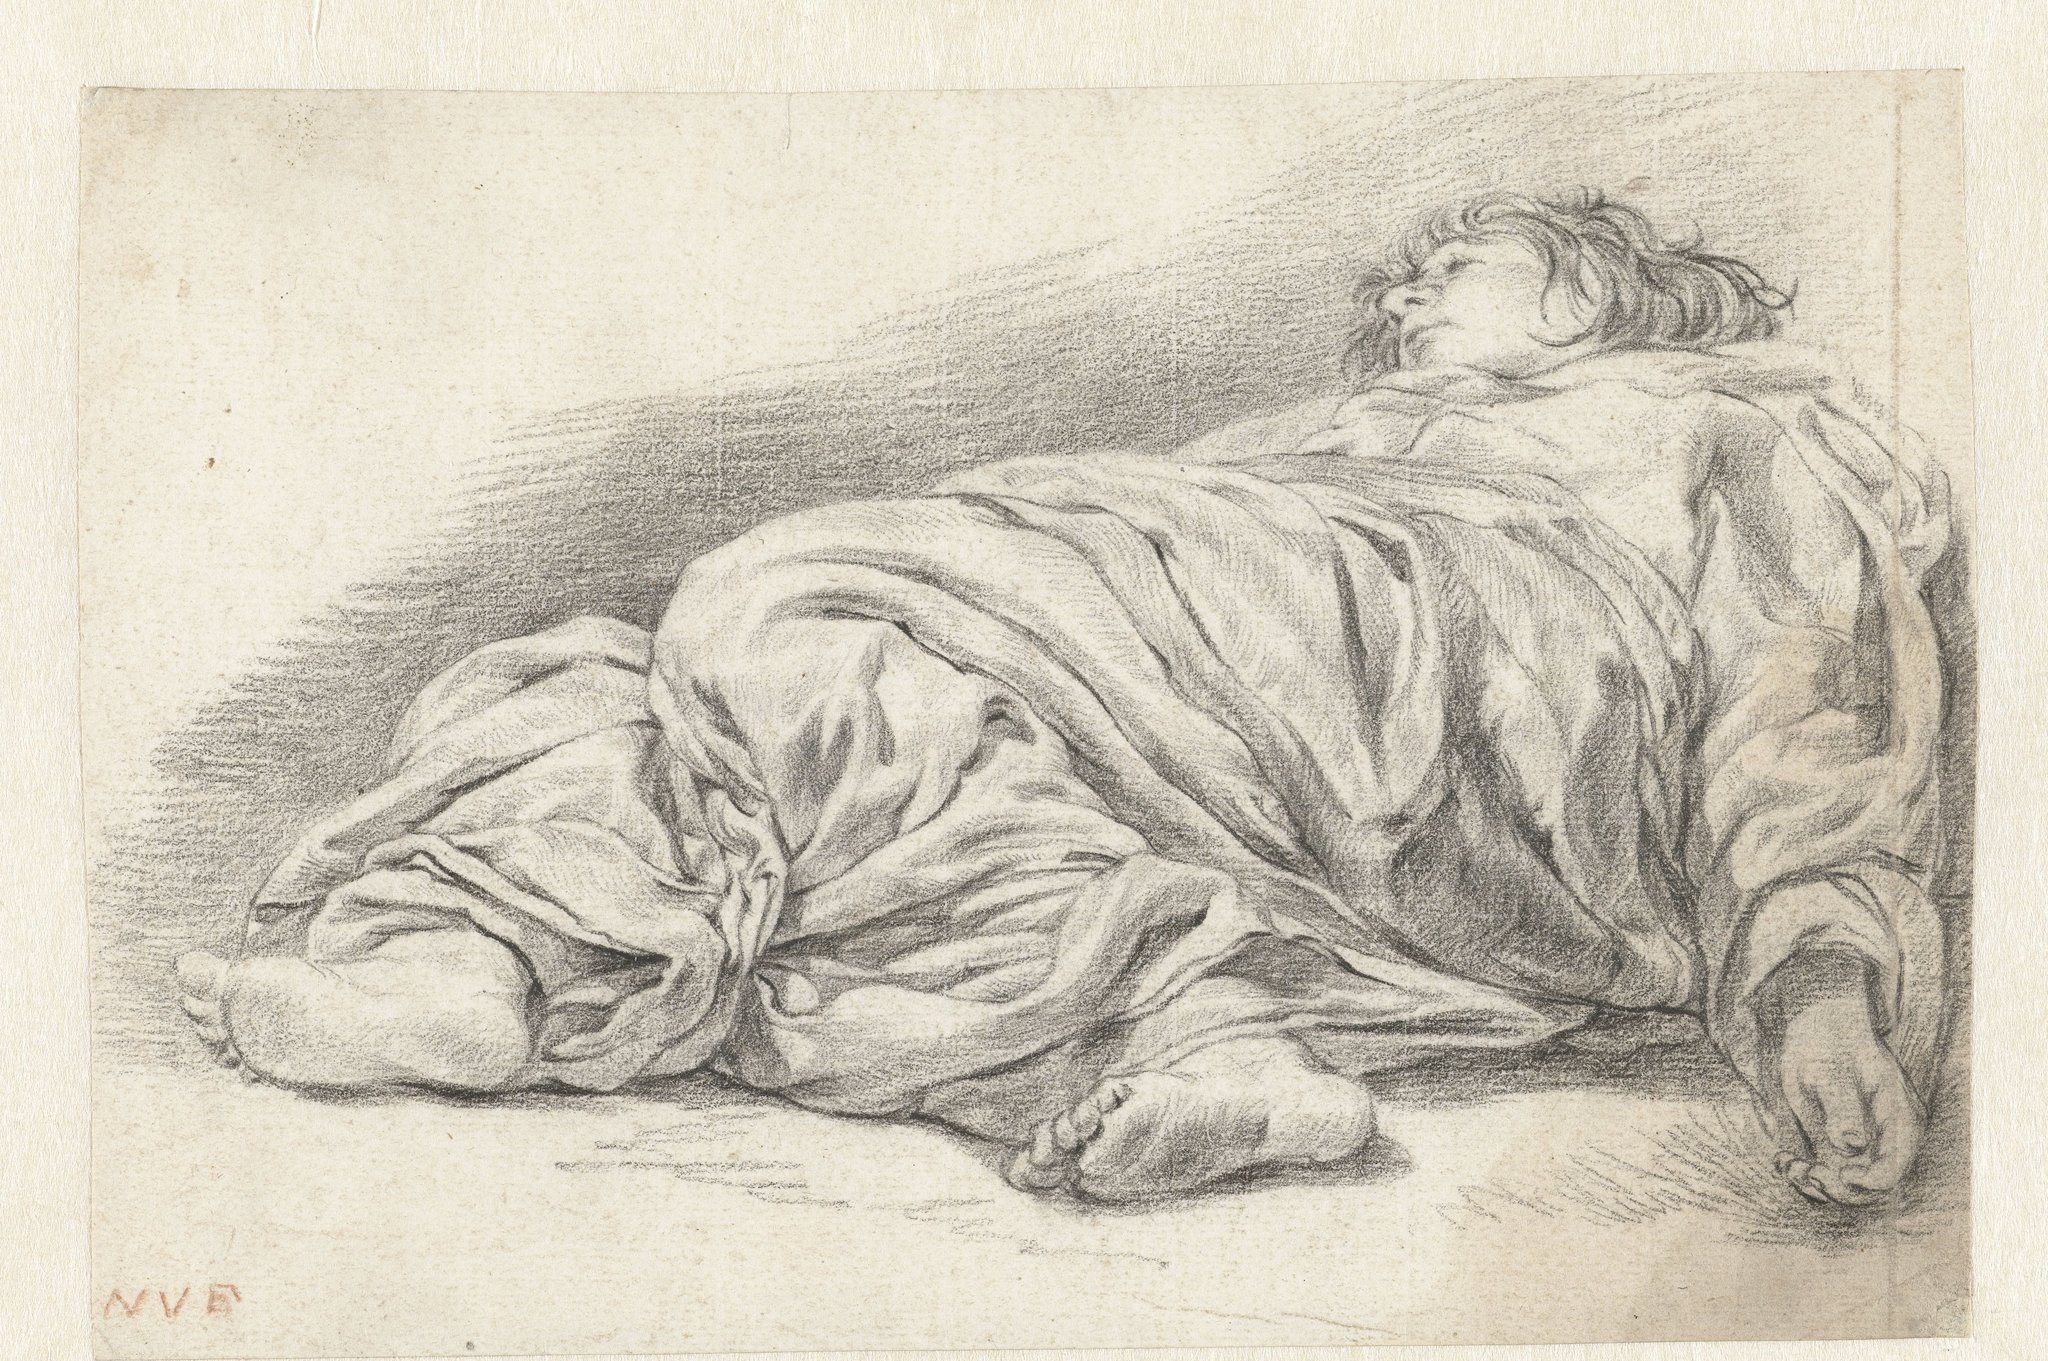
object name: drawing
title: Studie van een liggende jongen met een wijde mantel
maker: monogrammist nve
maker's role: draughtsman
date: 1600-1699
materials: chalk, paper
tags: boy (child between toddler and youth), lying figure